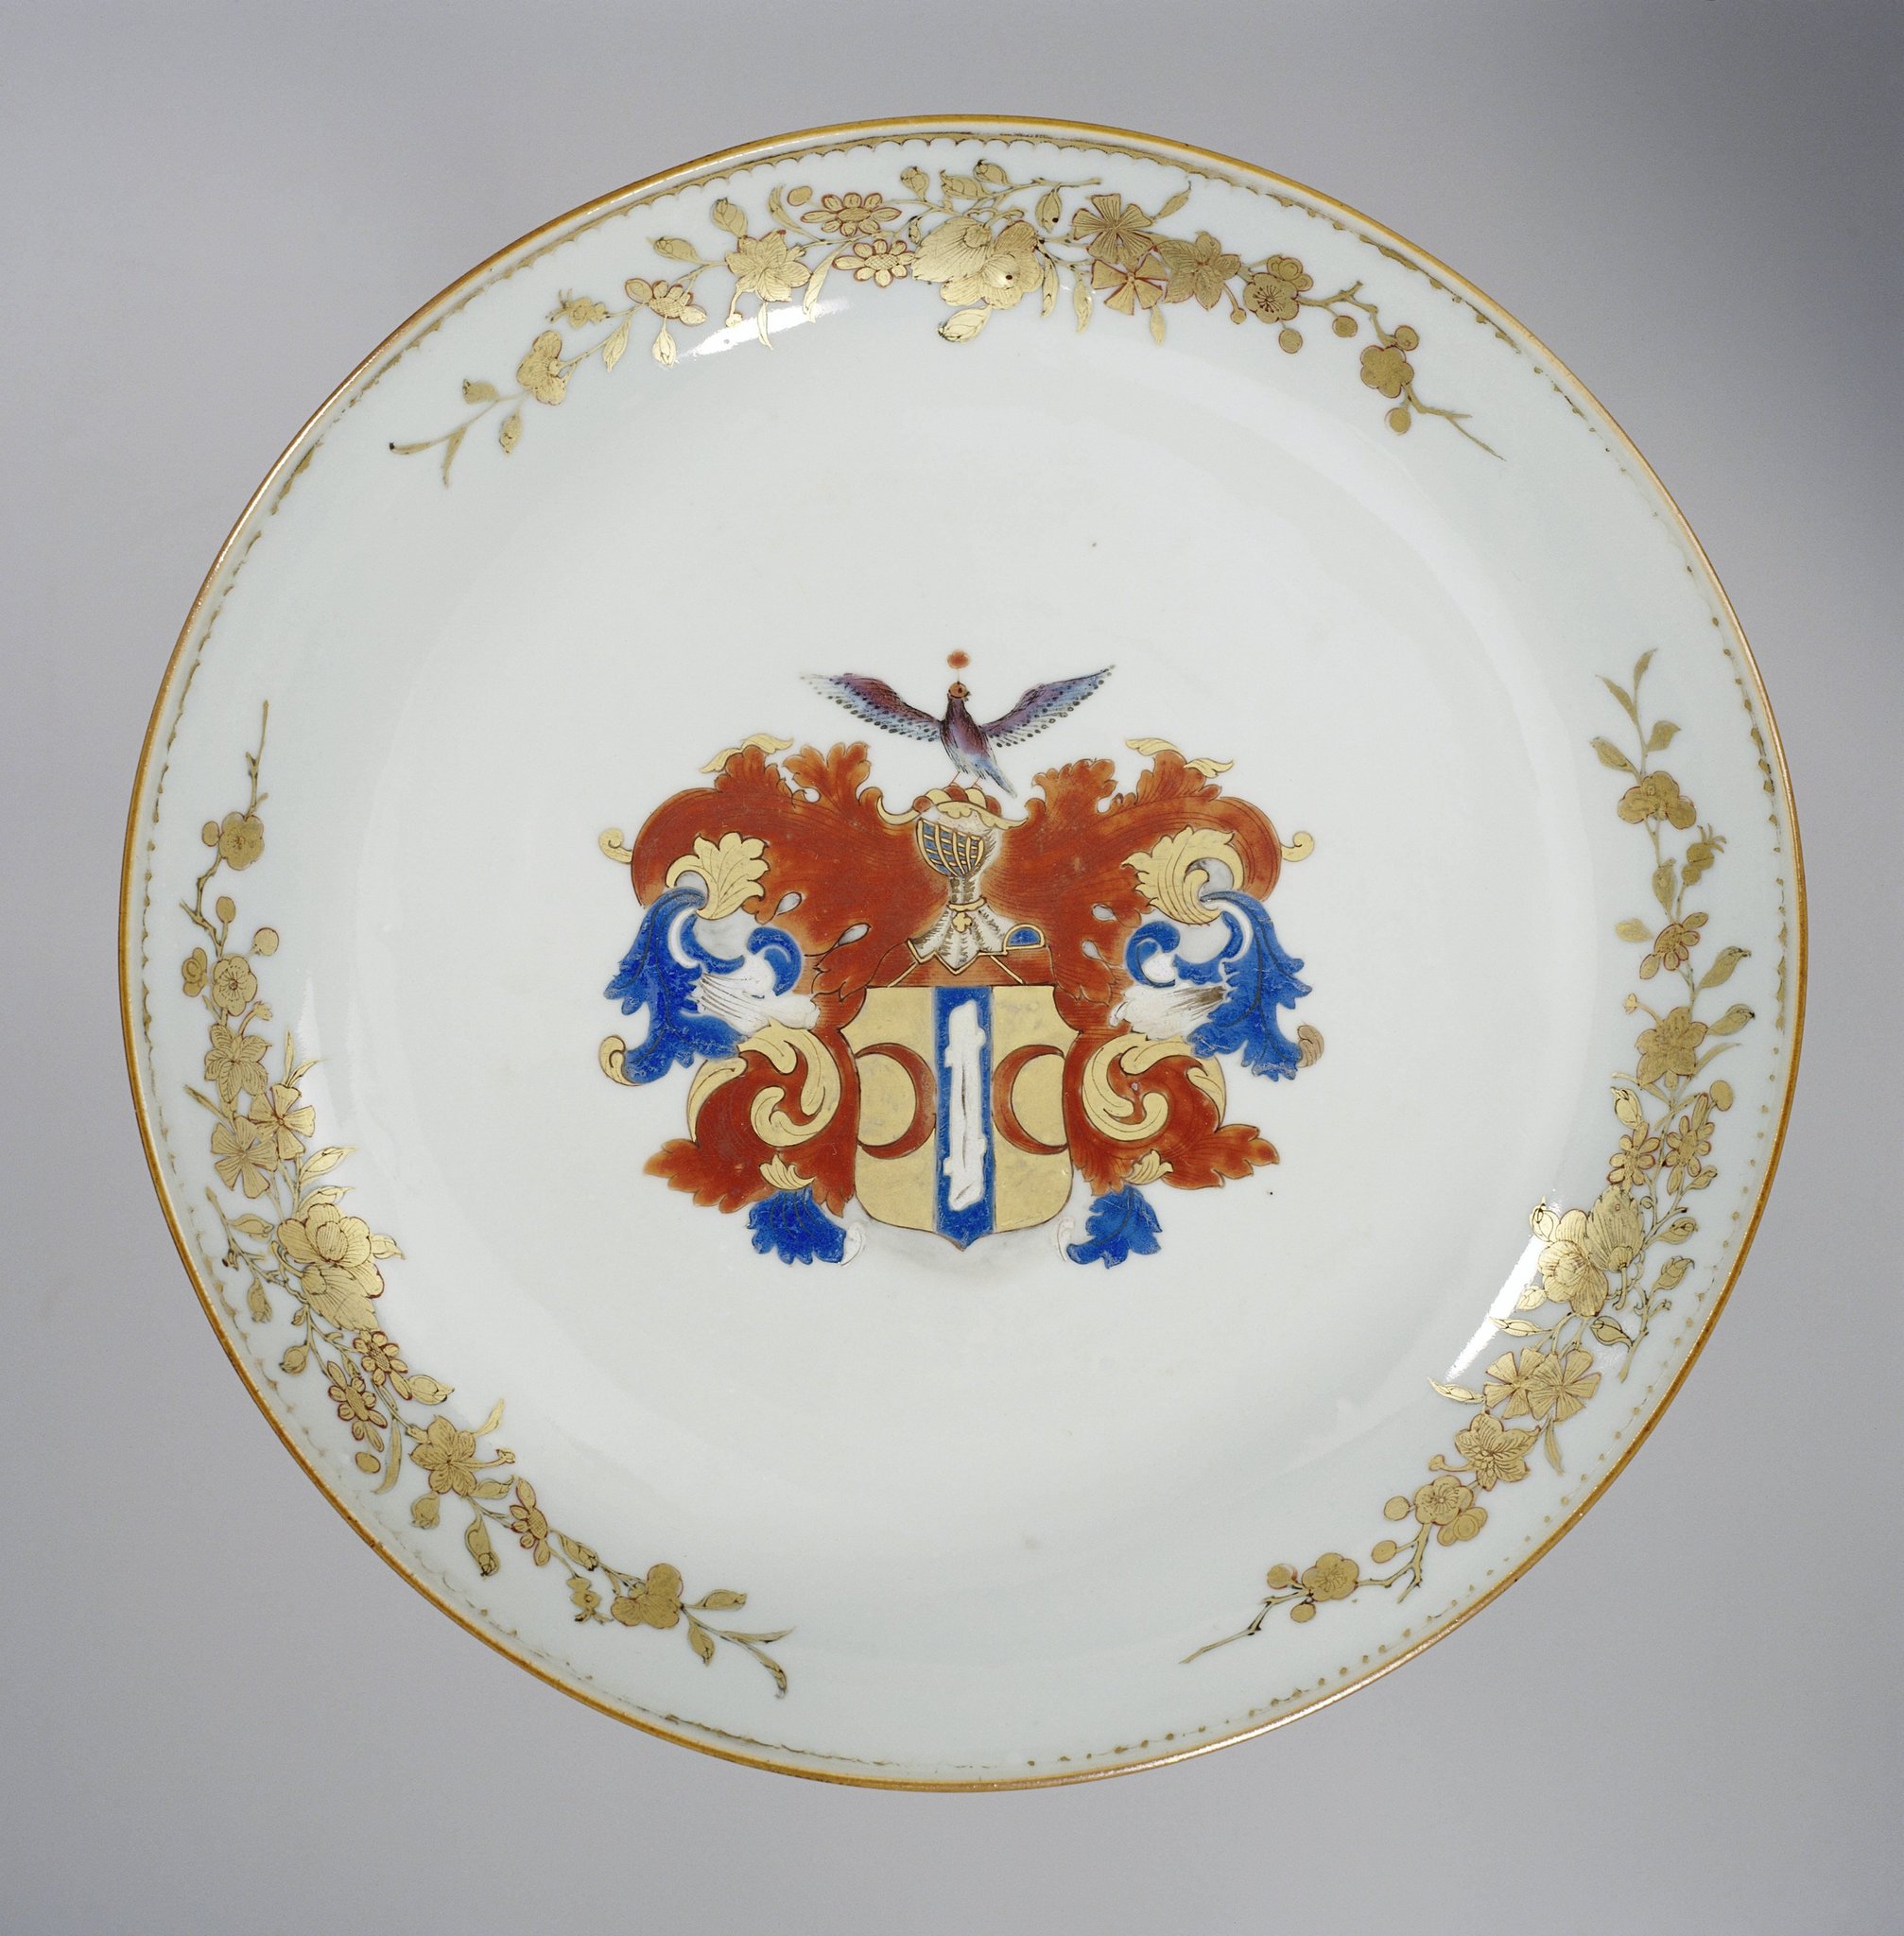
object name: dish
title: Saucer-dish with the arms of the Valckenier family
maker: Anonymous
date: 1725-1749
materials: glaze, gold, paint, porcelain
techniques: firing, gilding, turning, vitrification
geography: china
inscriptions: label: ‘Lefebvre Antiquaire/ 55. r. de Chateaudun PARIS/ no. 5626 SIL HSS’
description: Deze schotel is onderdeel van een dinerservies dat waarschijnlijk werd besteld door Adriaan Valckenier (1695-1751). Hij begon in 1714 zijn carrière in Batavia, bekleedde verschillende posities en werd in 1737 gouverneur-generaal van Nederlands Oost-Indië. In 1741 werd hij op Kaap de Goede Hoop gearresteerd vanwege zijn betrokkenheid bij het doden van onschuldige Chinezen in Batavia in 1740. In 1751 overleed hij in Batavia nog voordat zijn proces was beëindigd. Het porselein met daarop het wapen van de familie Valckenier bestond ongeveer uit 3500 tot 4000 stuks. Een groot deel hiervan is verloren gegaan met de Oost-Indiëvaarder Amsterdam, die op zijn terugreis naar Nederland zonk.